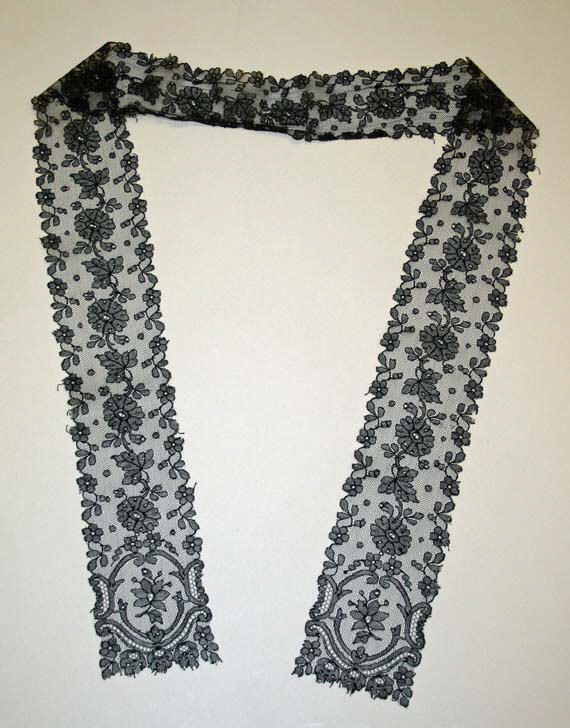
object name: barbe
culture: american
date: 1870-1892